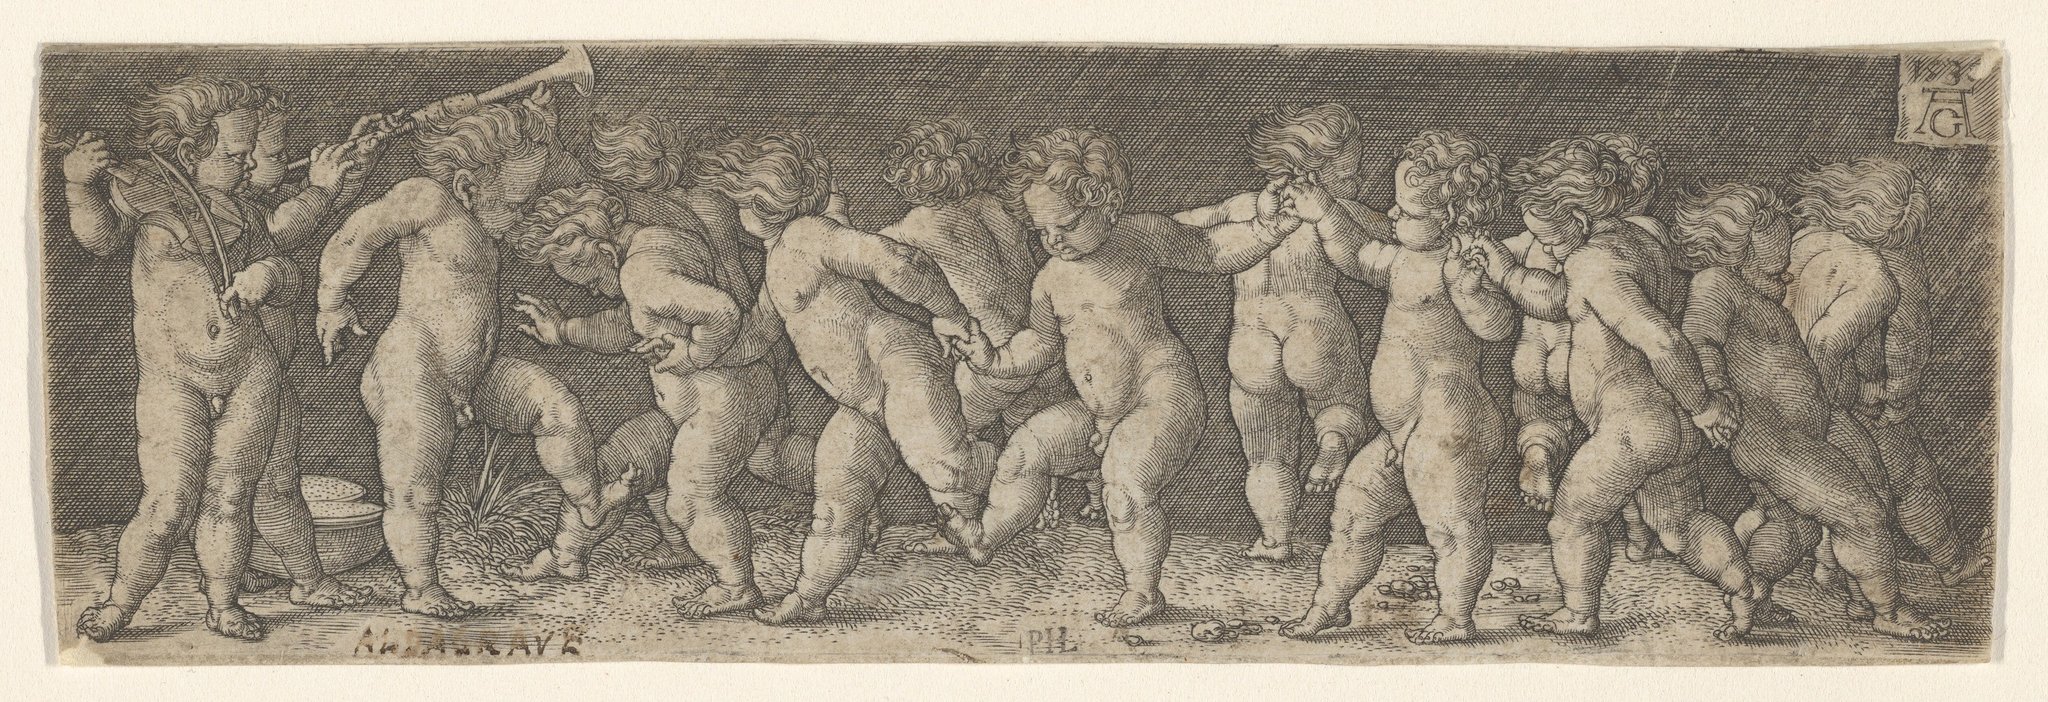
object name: print ornament architecture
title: Fifteen Nude Children Dancing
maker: heinrich aldegrever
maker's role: artist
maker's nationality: german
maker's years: 1502-1561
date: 1535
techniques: engraving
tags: musical instruments,children,dancing